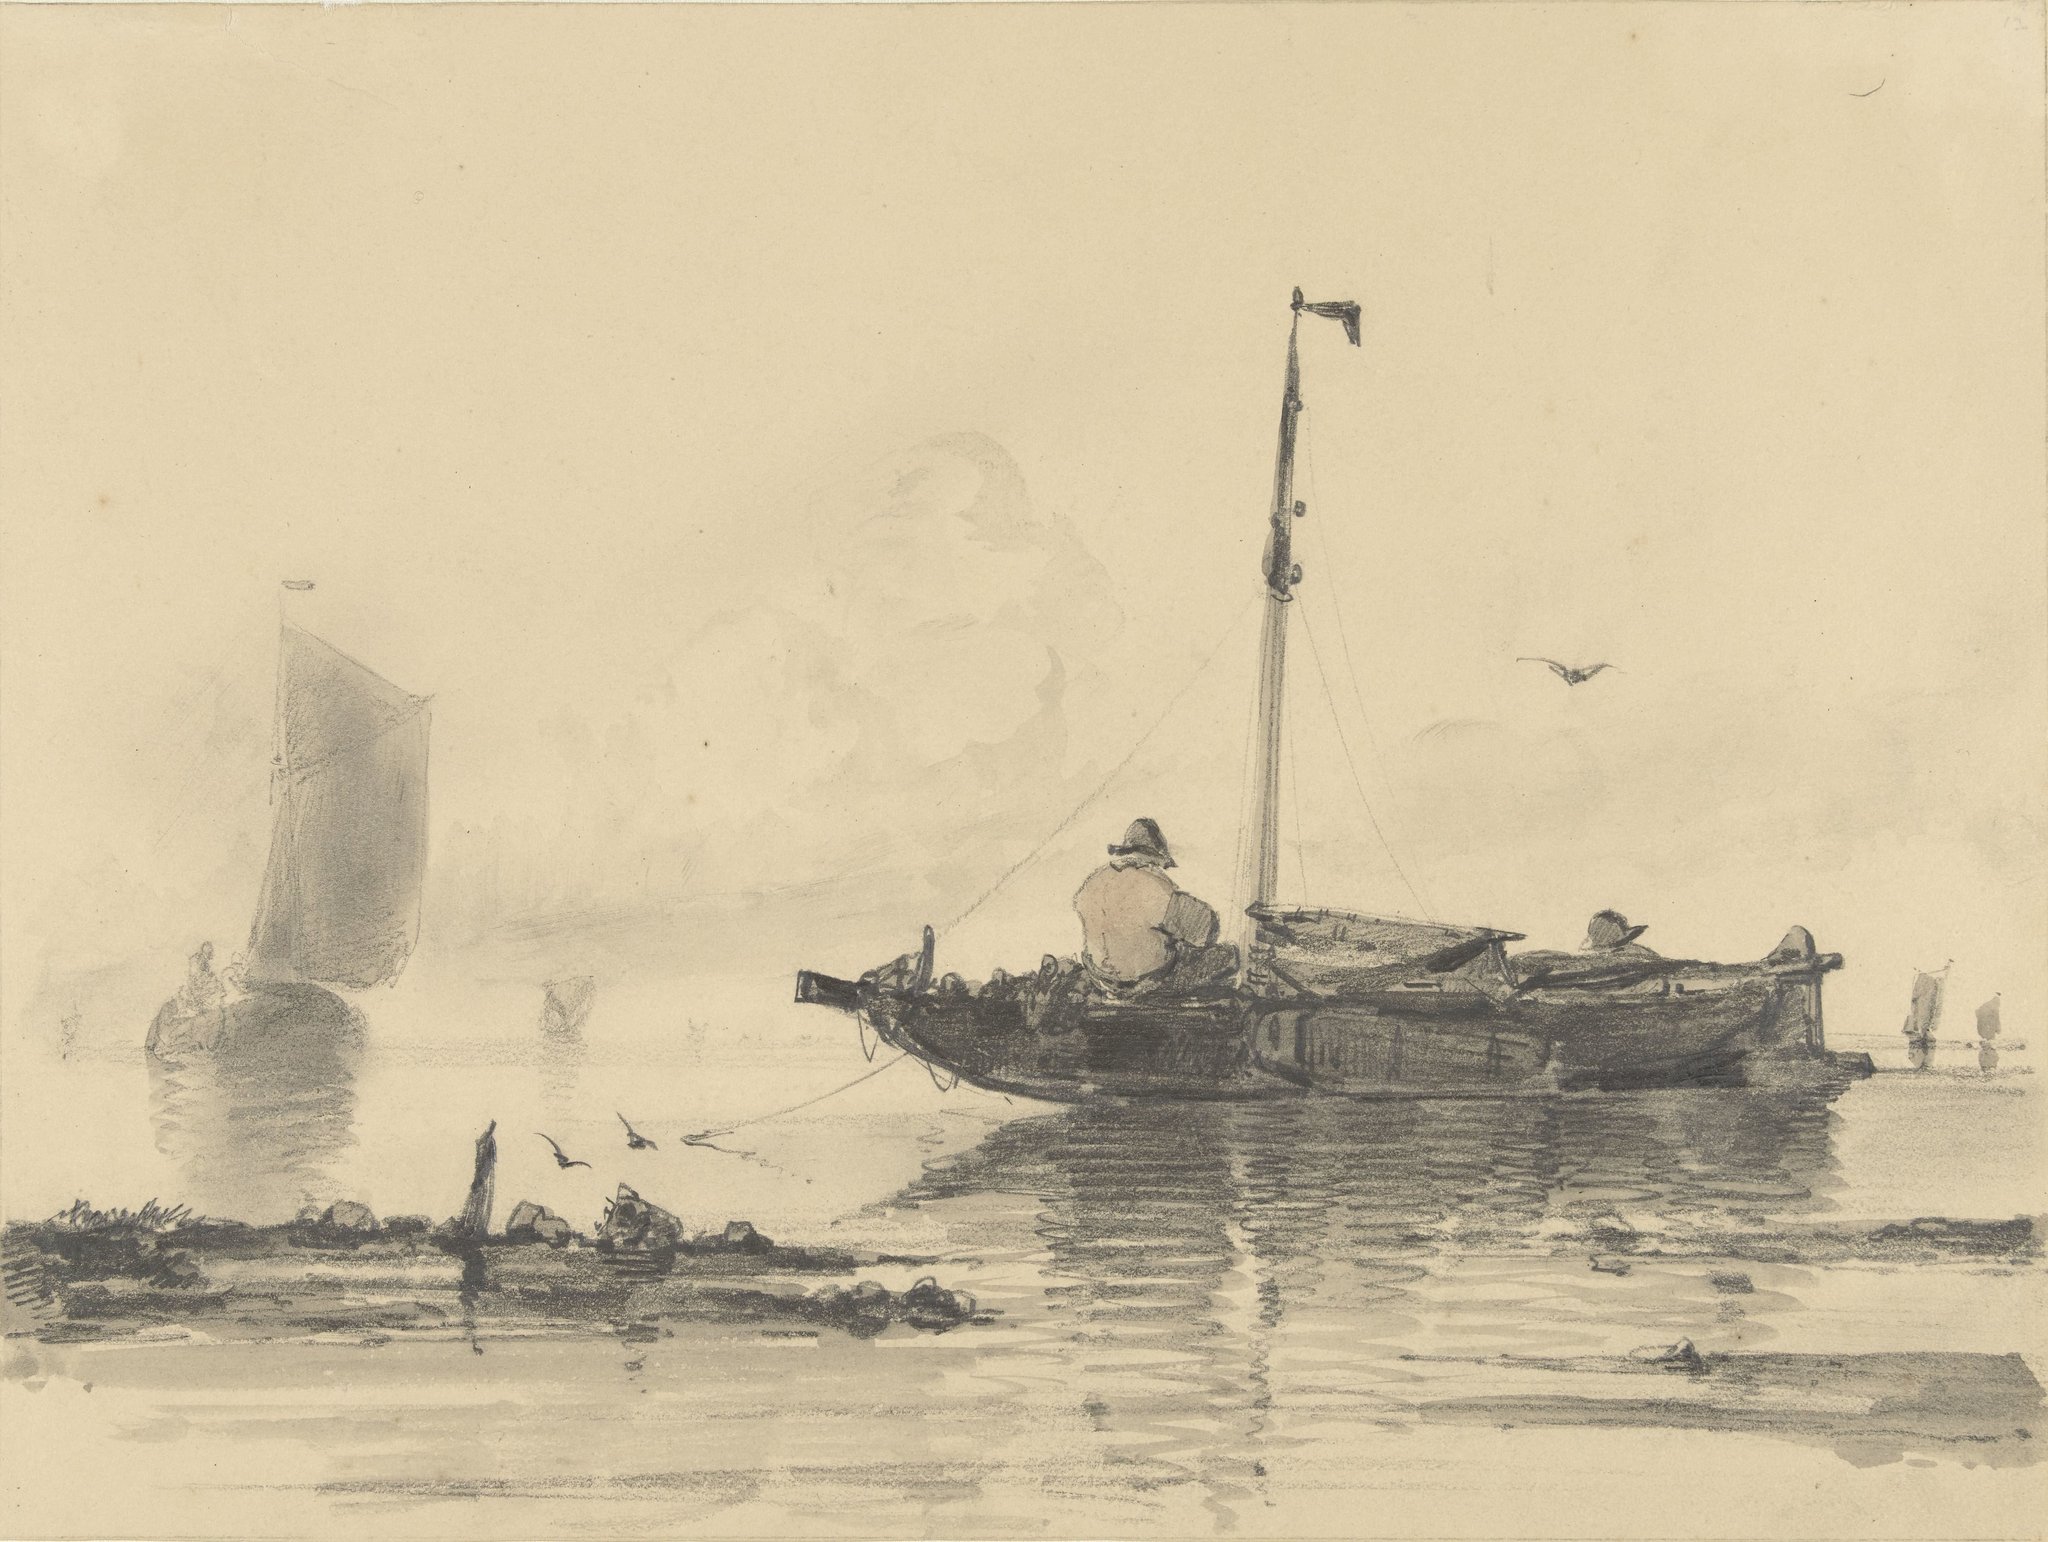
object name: drawing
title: Twee mannen in een bootje op kalm water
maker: albertus van beest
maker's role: draughtsman, print maker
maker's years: 1820-1860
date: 1830-1860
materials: chalk, paper, pencil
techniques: brush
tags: sailing-ship, sailing-boat